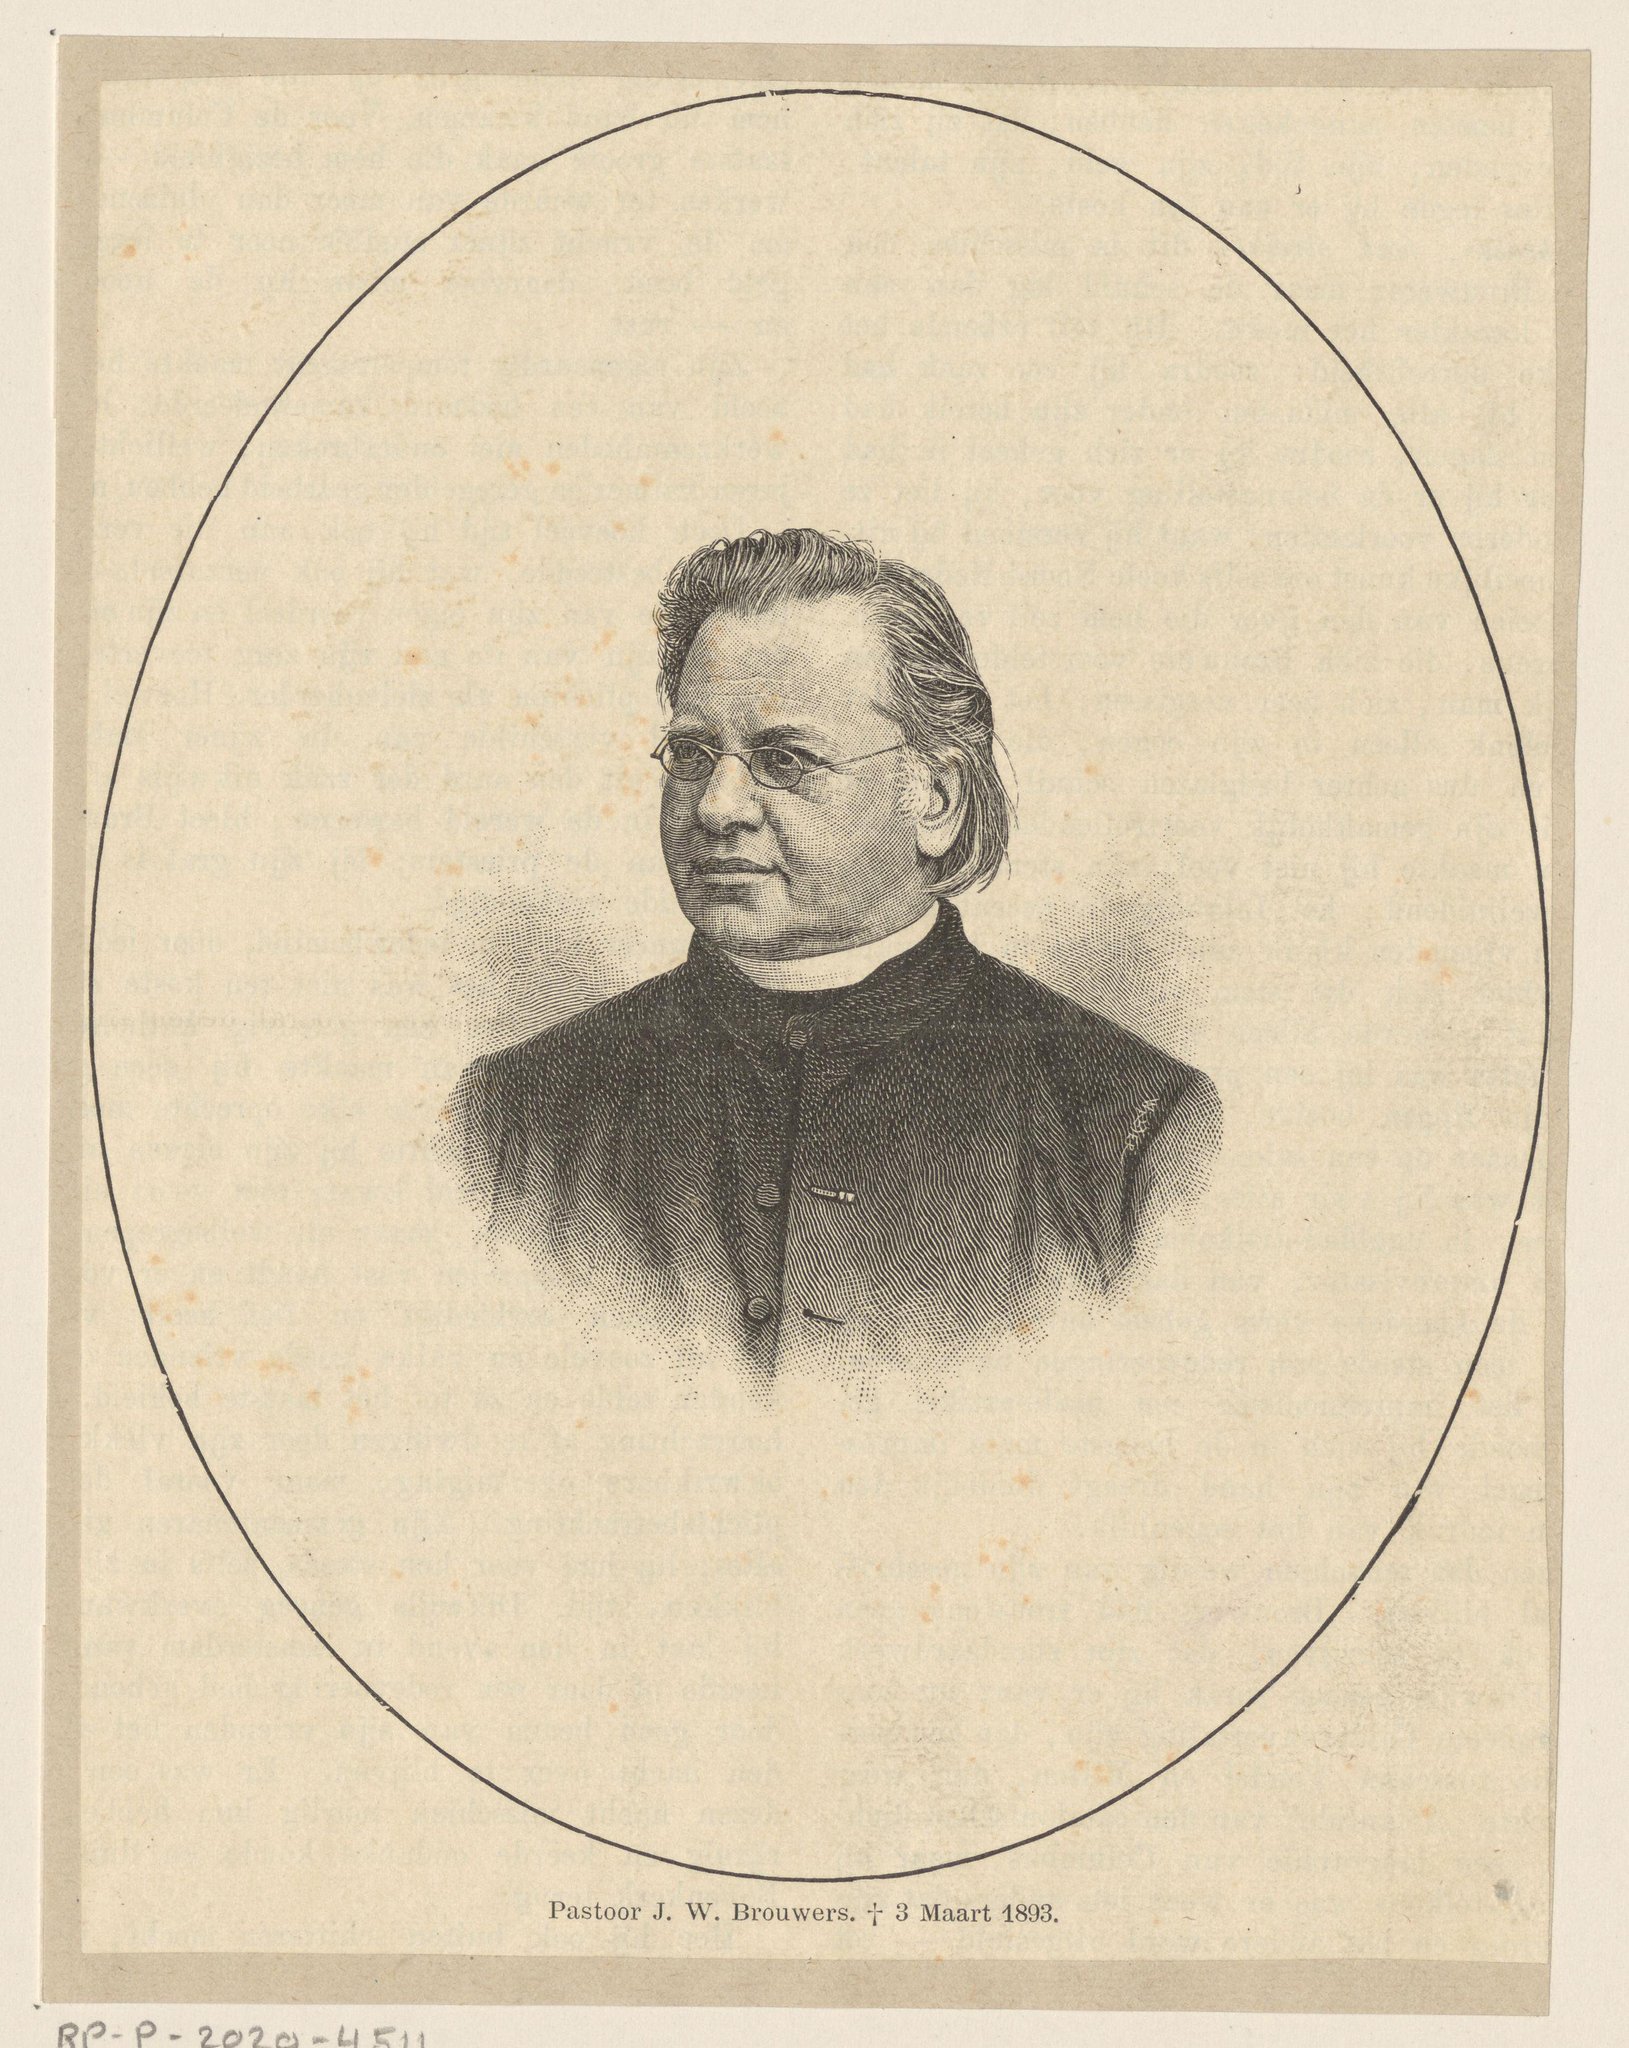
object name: print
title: Portret van Jan Willem Brouwers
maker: walter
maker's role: draughtsman, print maker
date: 1893-1895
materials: paper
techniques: letterpress printing, engraving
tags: priest, historical persons